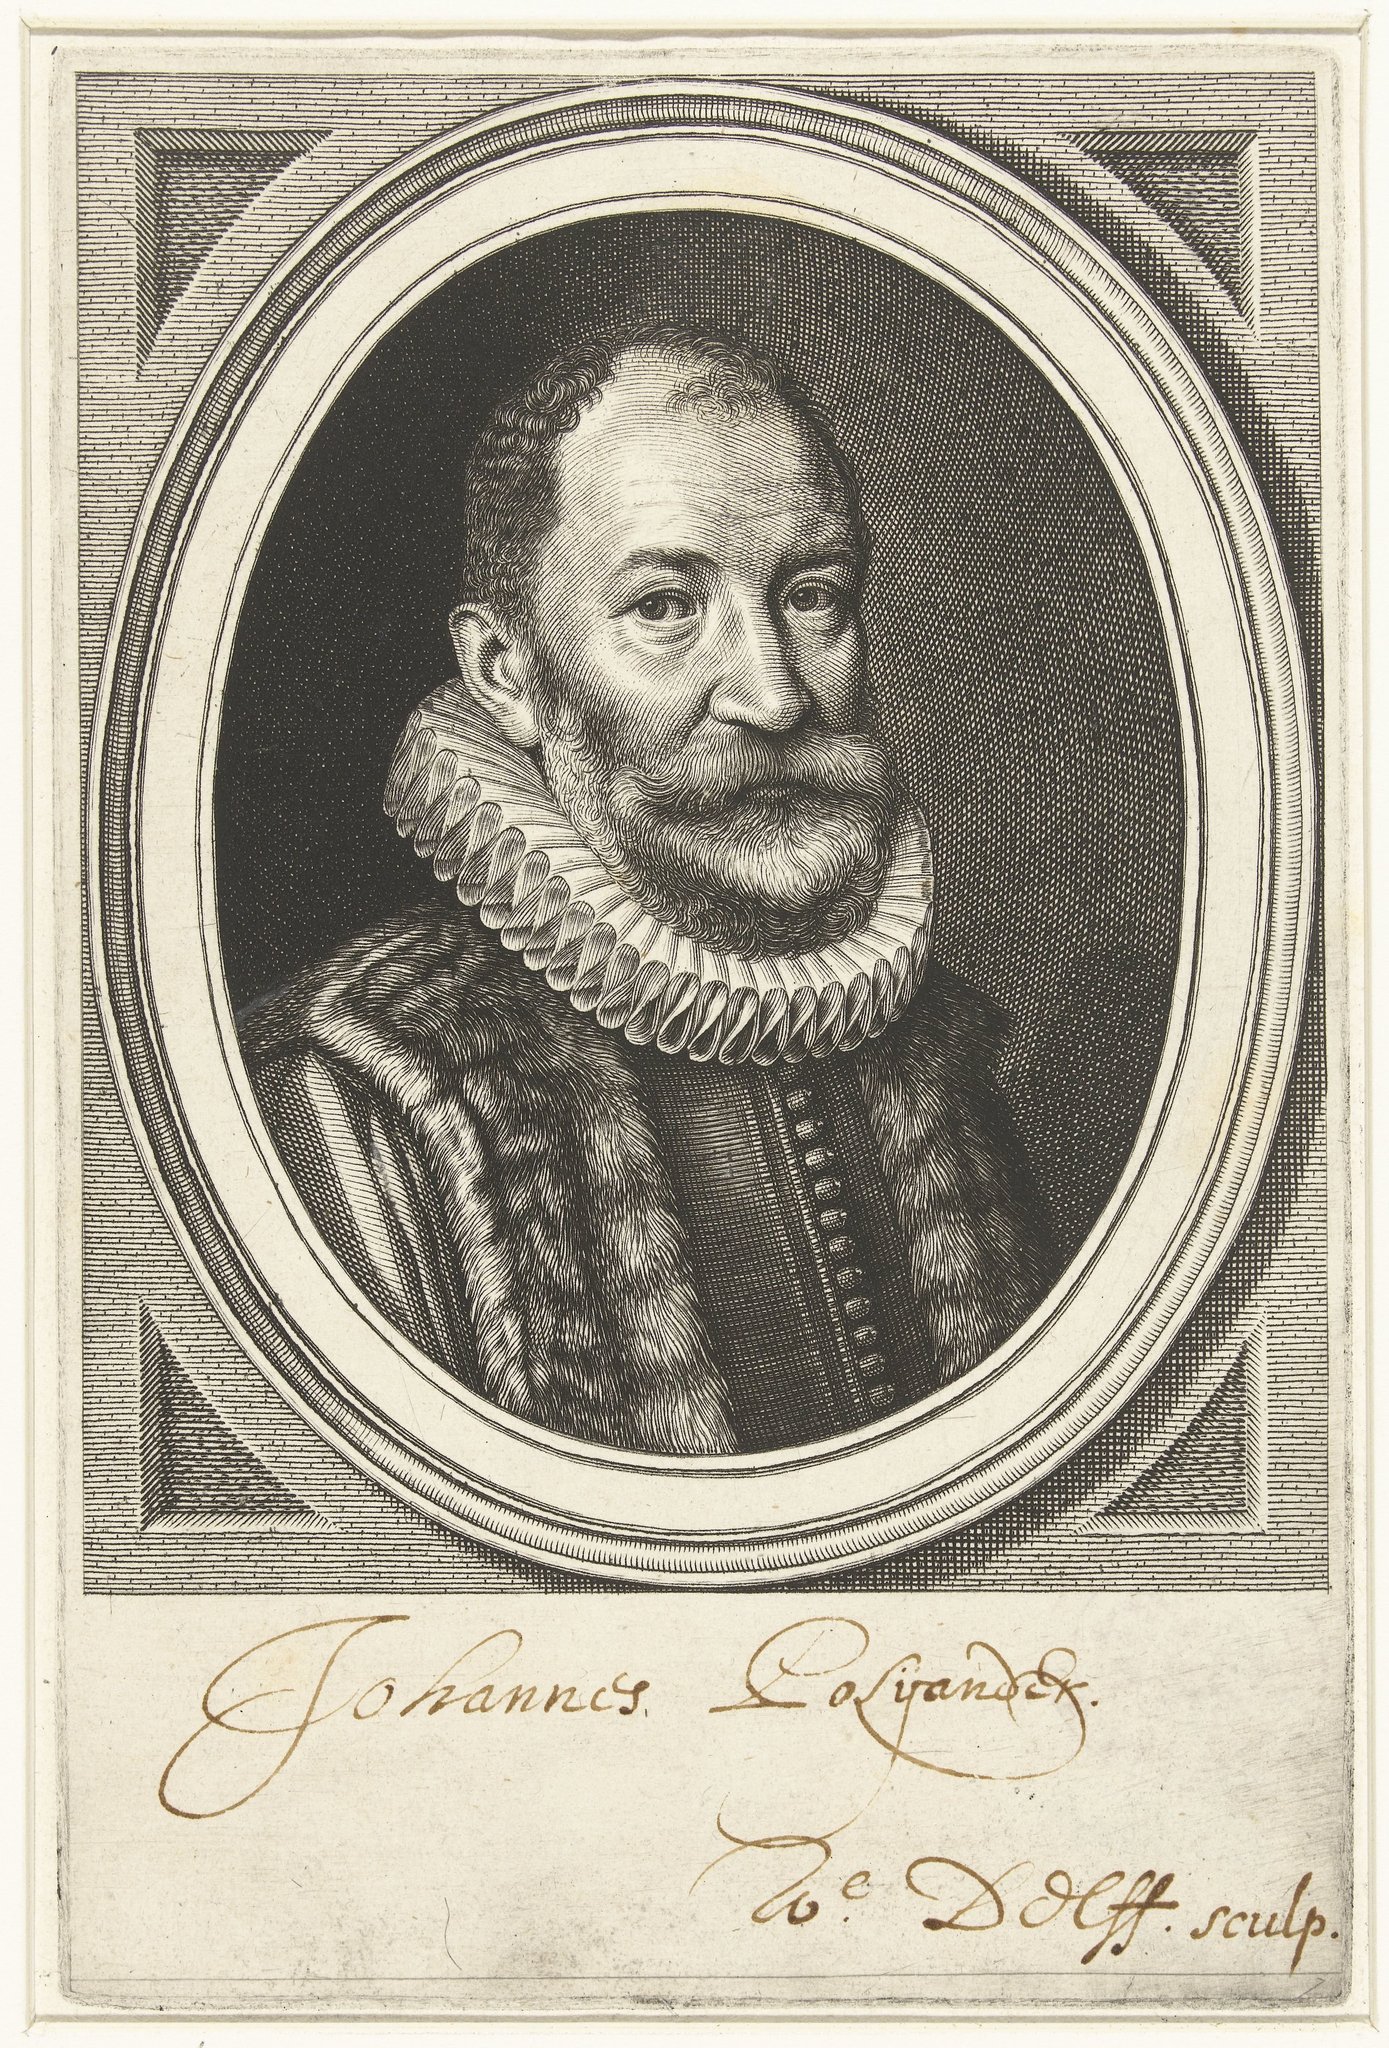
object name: print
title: Portret van Johannes Polyander van Kerkhoven op 51-jarige leeftijd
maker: willem jacobsz delff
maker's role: draughtsman, print maker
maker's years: 1580-1638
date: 1619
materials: paper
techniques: engraving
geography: delft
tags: leiden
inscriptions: collector's mark: Lugt 240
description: Portret van Johannes Polyander van Kerkhoven op 51-jarige leeftijd, borststuk met molenkraag en toga in ovale omlijsting.